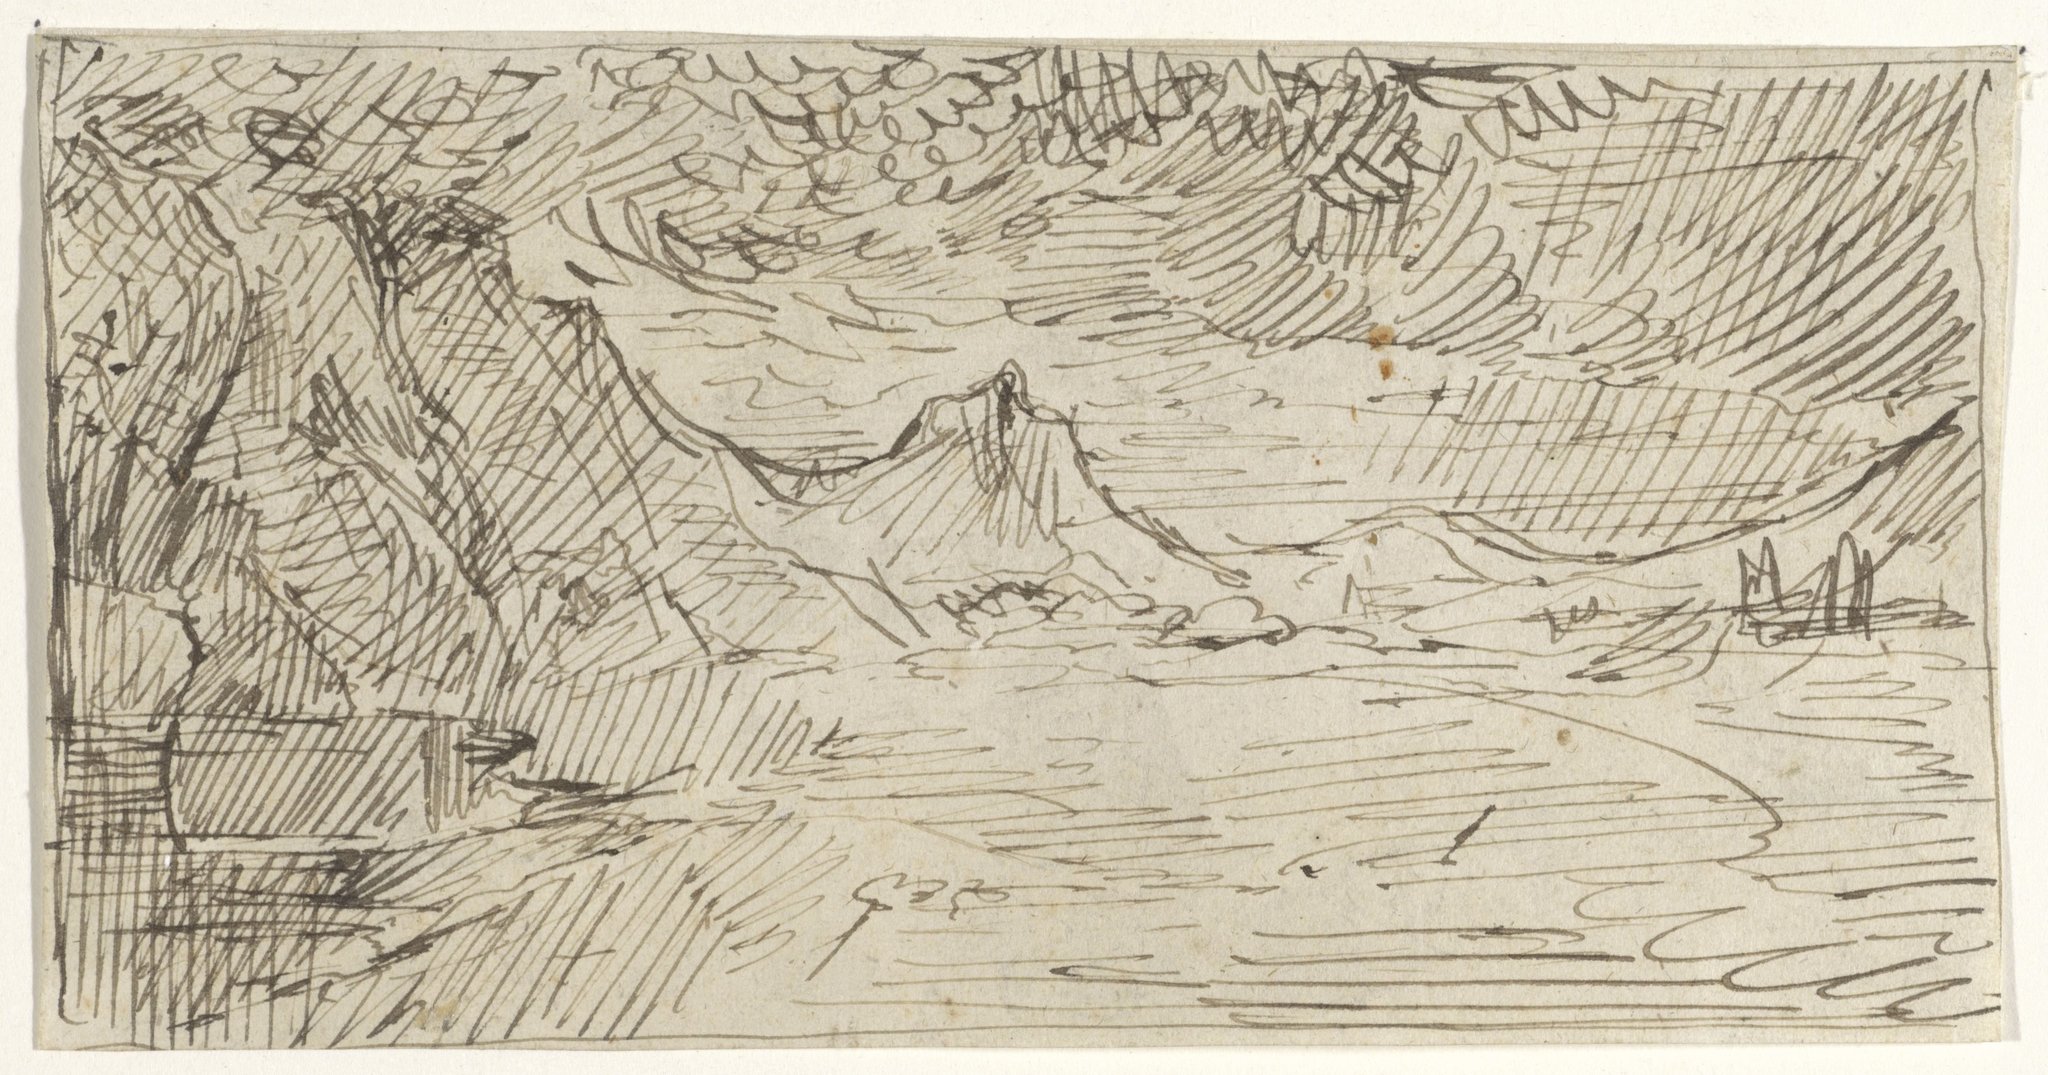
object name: drawing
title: Berglandschap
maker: thomas cool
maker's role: draughtsman, painter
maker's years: 1851-1904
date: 1861-1904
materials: ink, paper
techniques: pen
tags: mountains